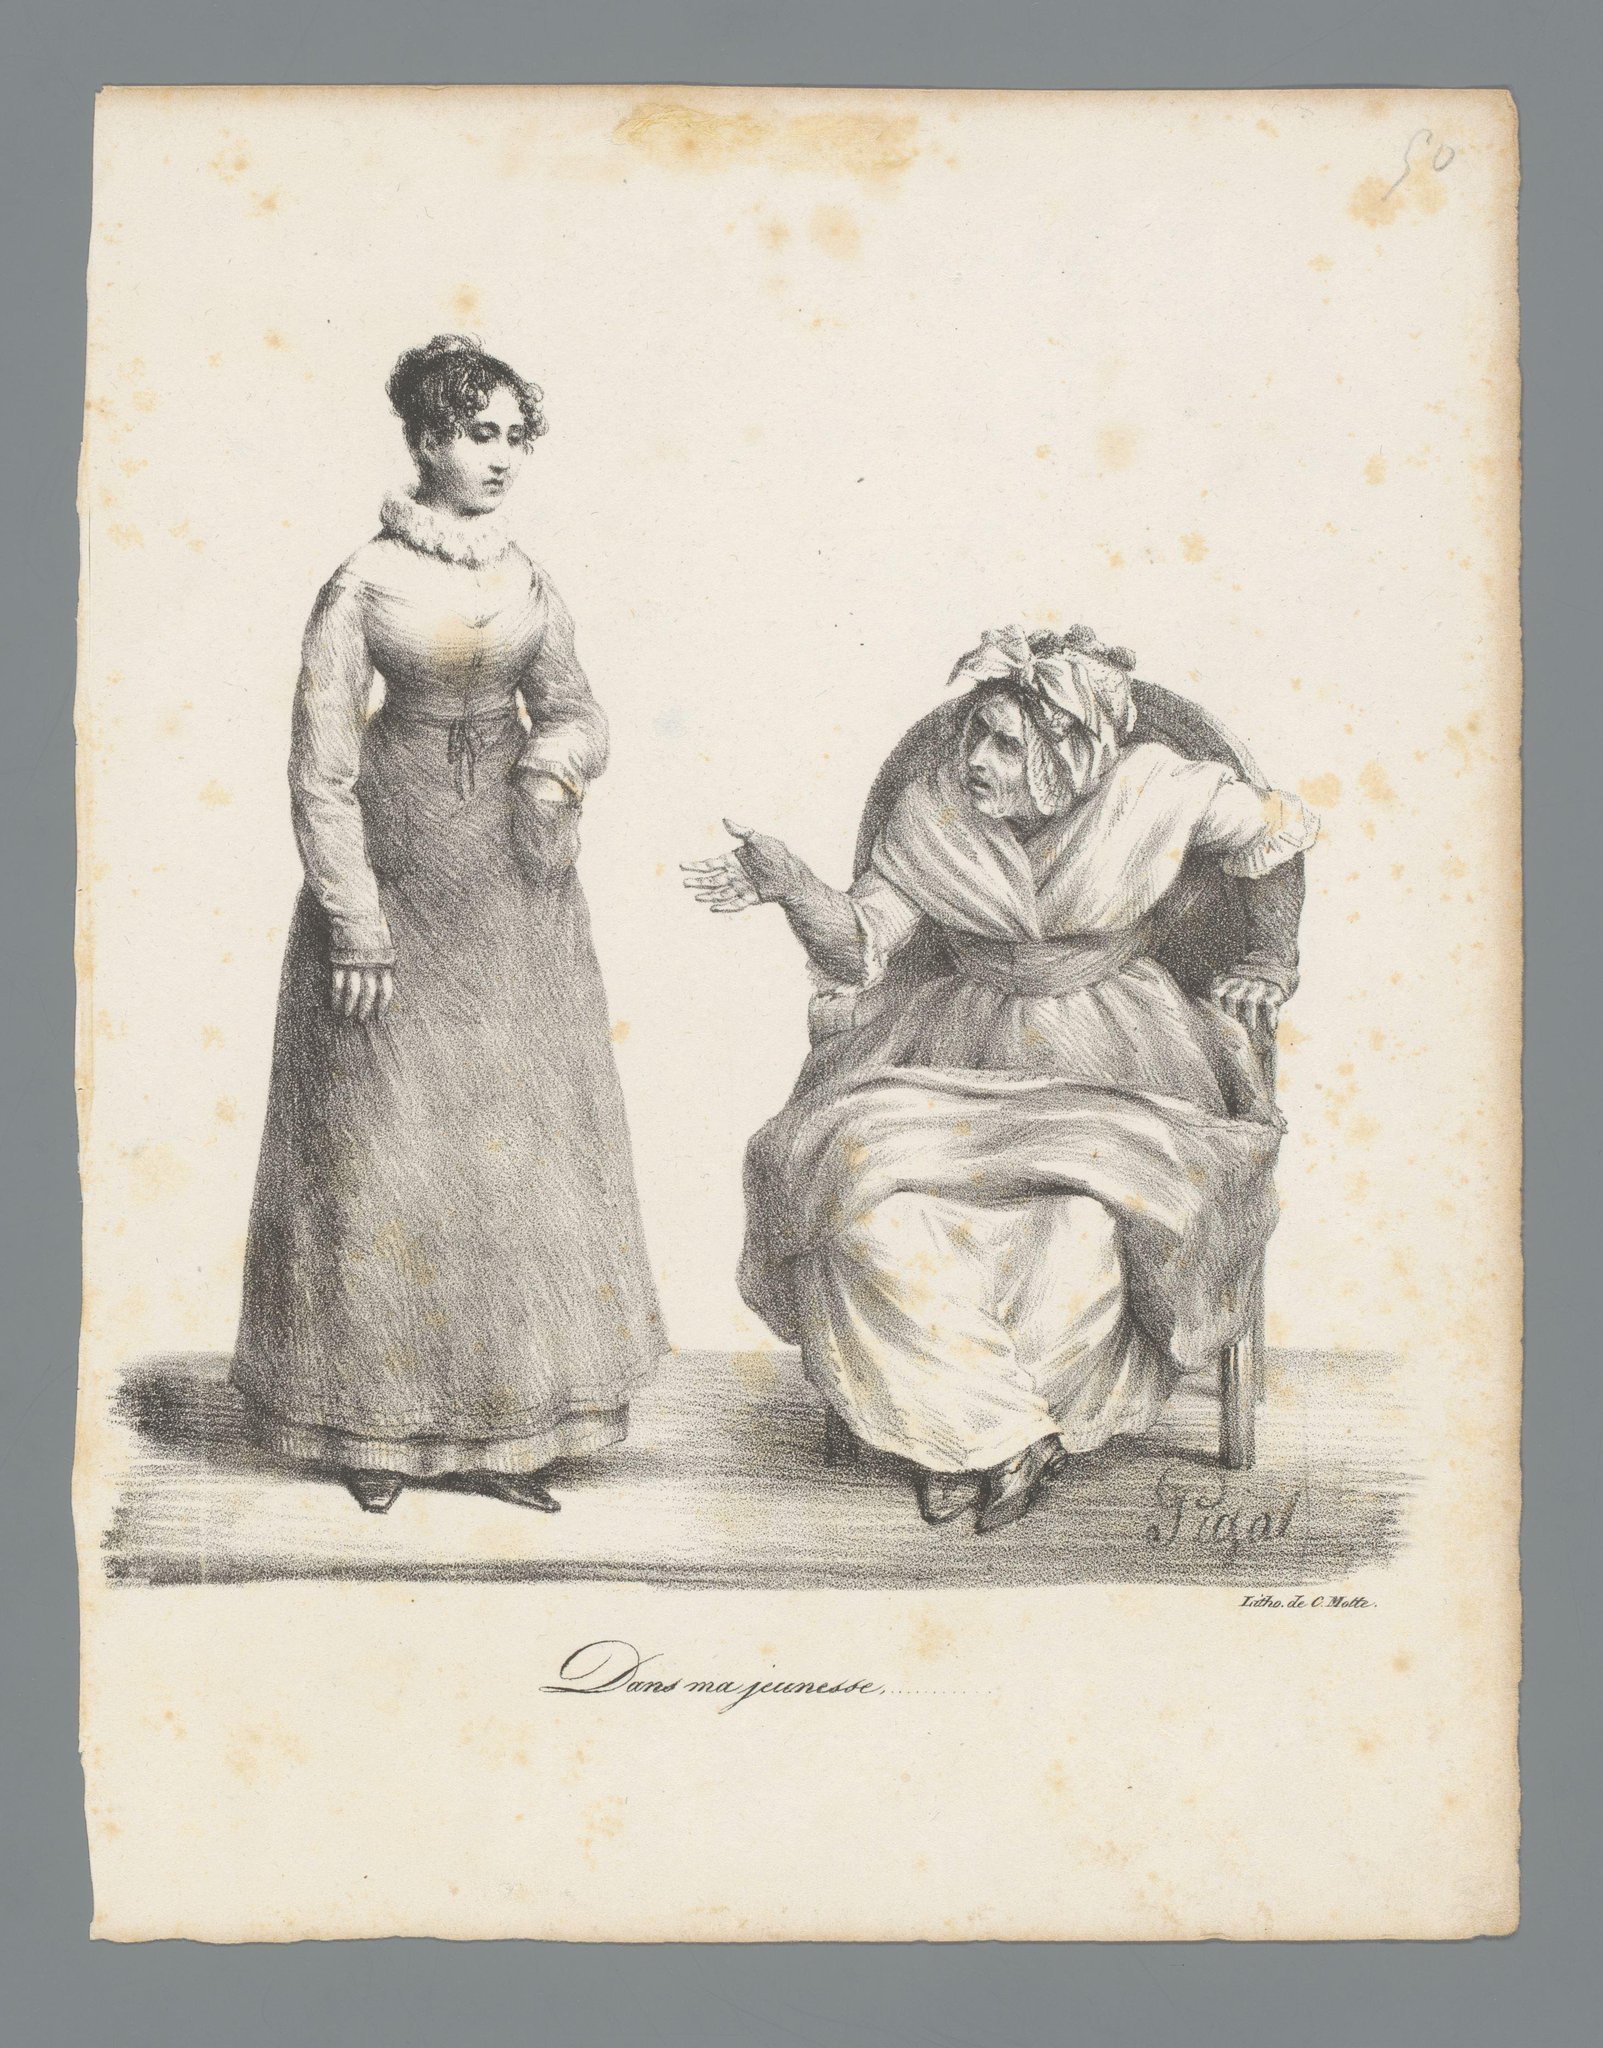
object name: print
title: Dans ma jeunesse,.........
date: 1822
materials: paper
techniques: lithograph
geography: paris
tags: adolescent, young woman, maiden, old woman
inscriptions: collector's mark: Lugt 2228